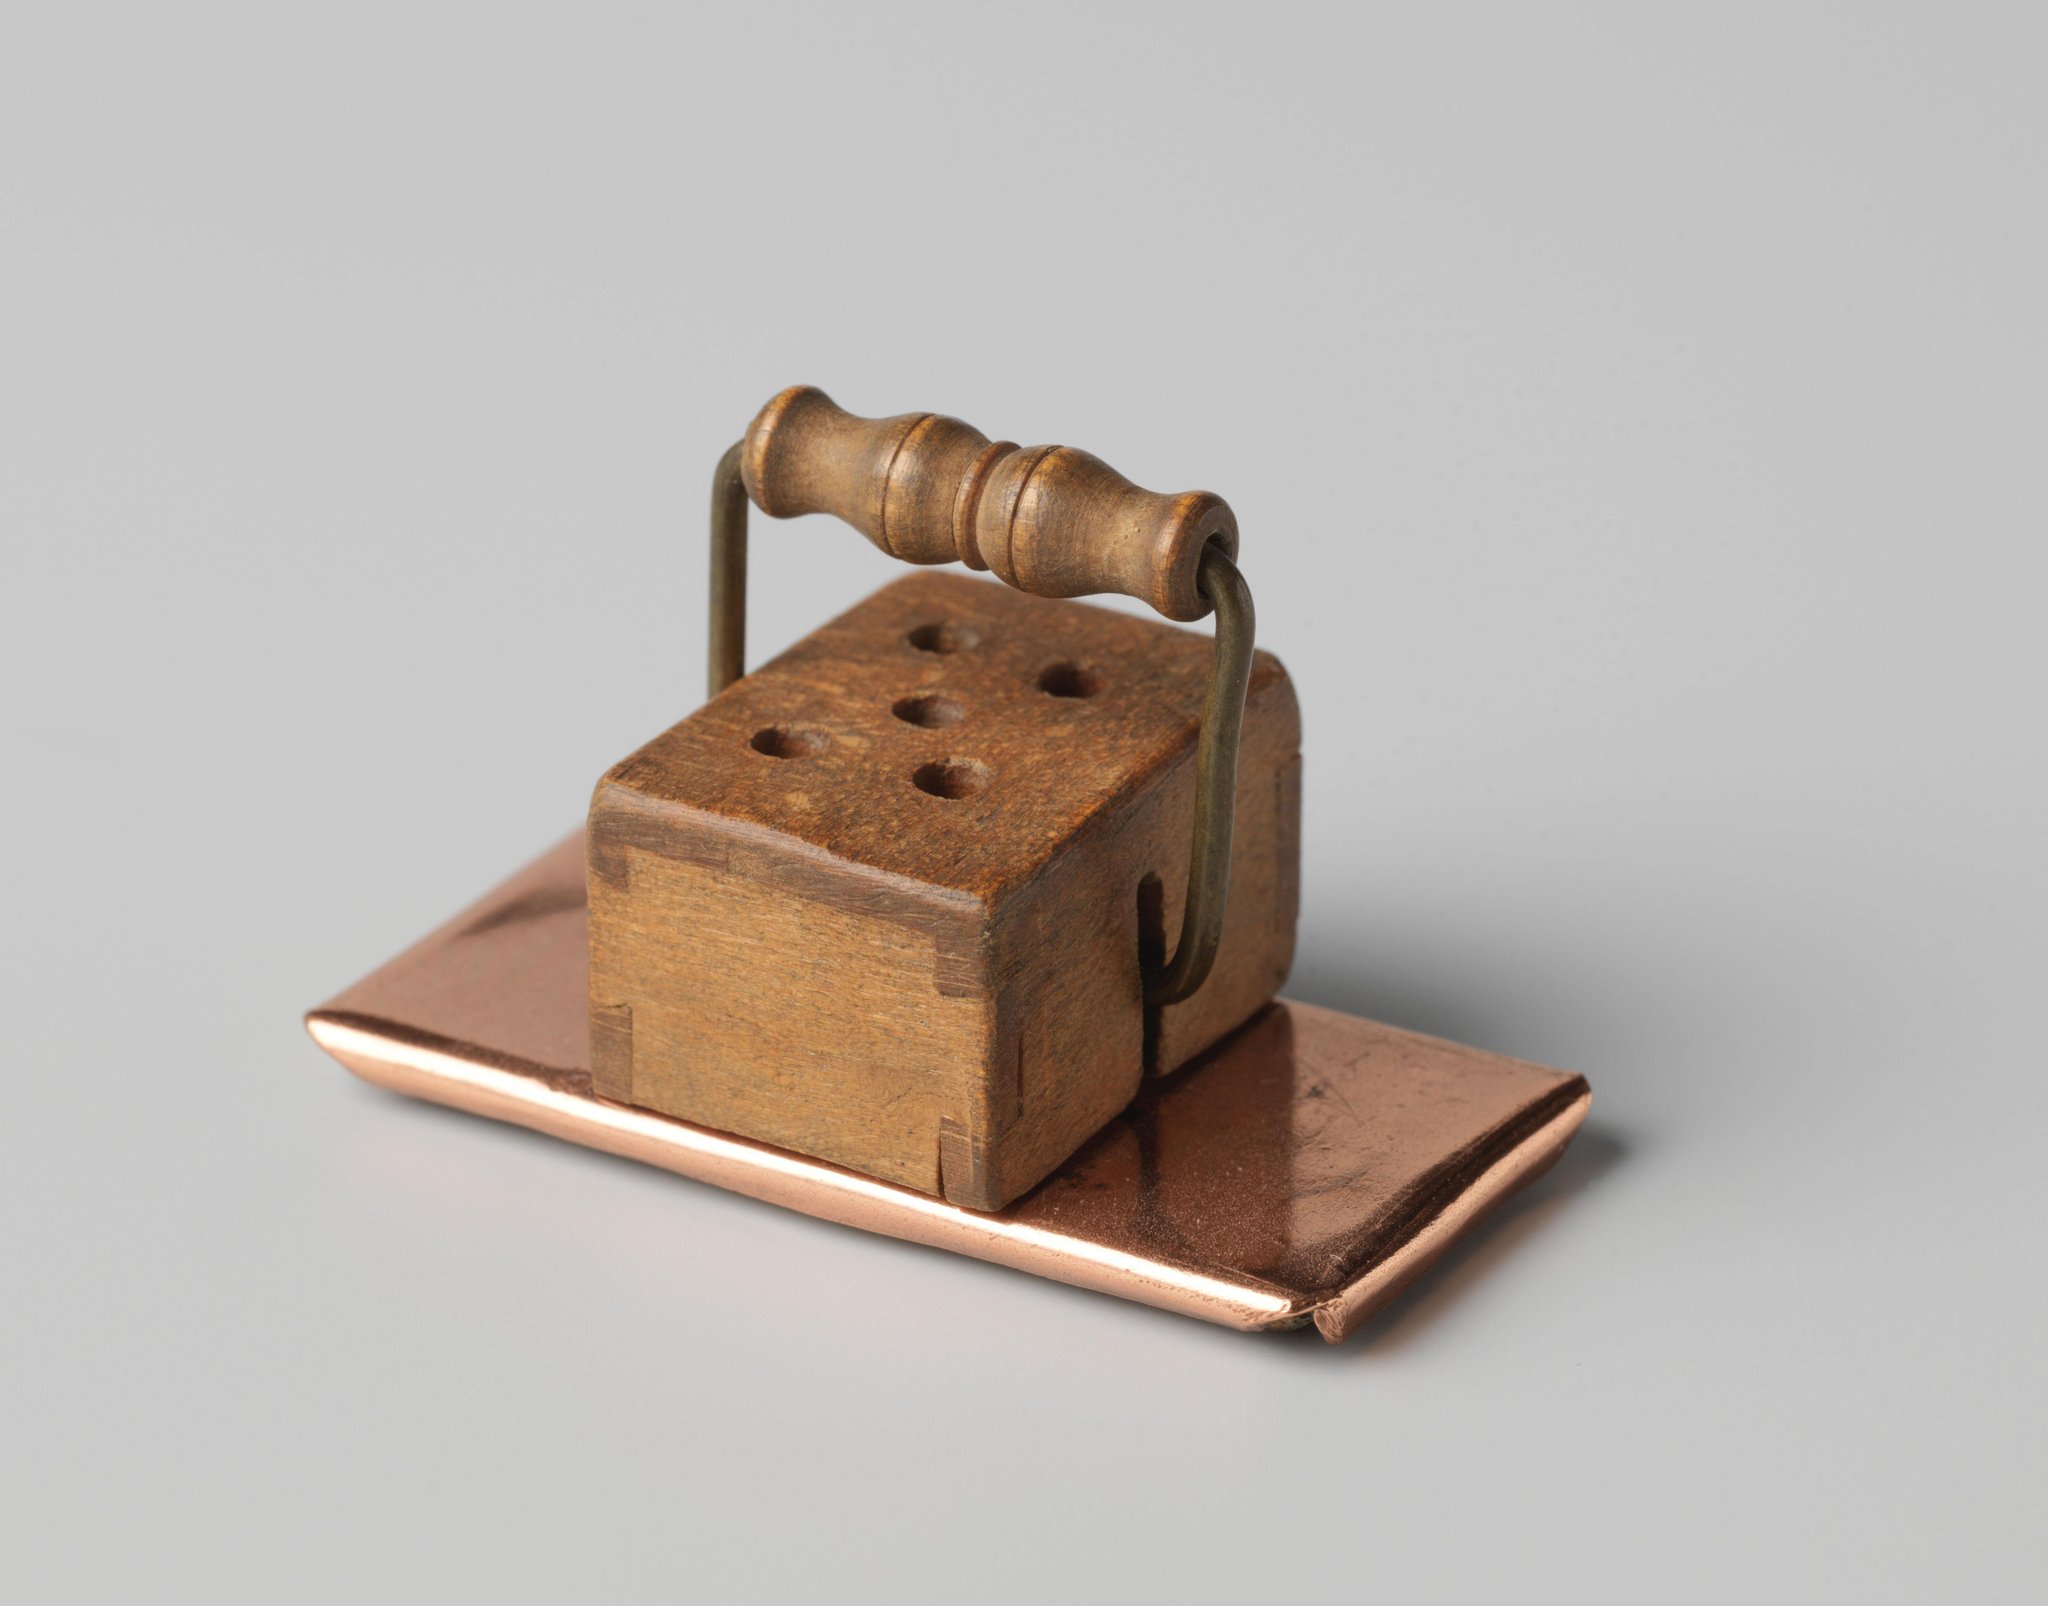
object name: reisstoof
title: Reisstoof met klapdeksel en handvat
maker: Anonymous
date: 1700-1799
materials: wood, copper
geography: amsterdam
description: Draagbare koperen stoof met een klapdeksel die is vastgezet op een voetenplank van koper om eikenhout. De beschermkap is gemaakt van beukenhout. Het houten handvat heeft gedraaide versieringen.